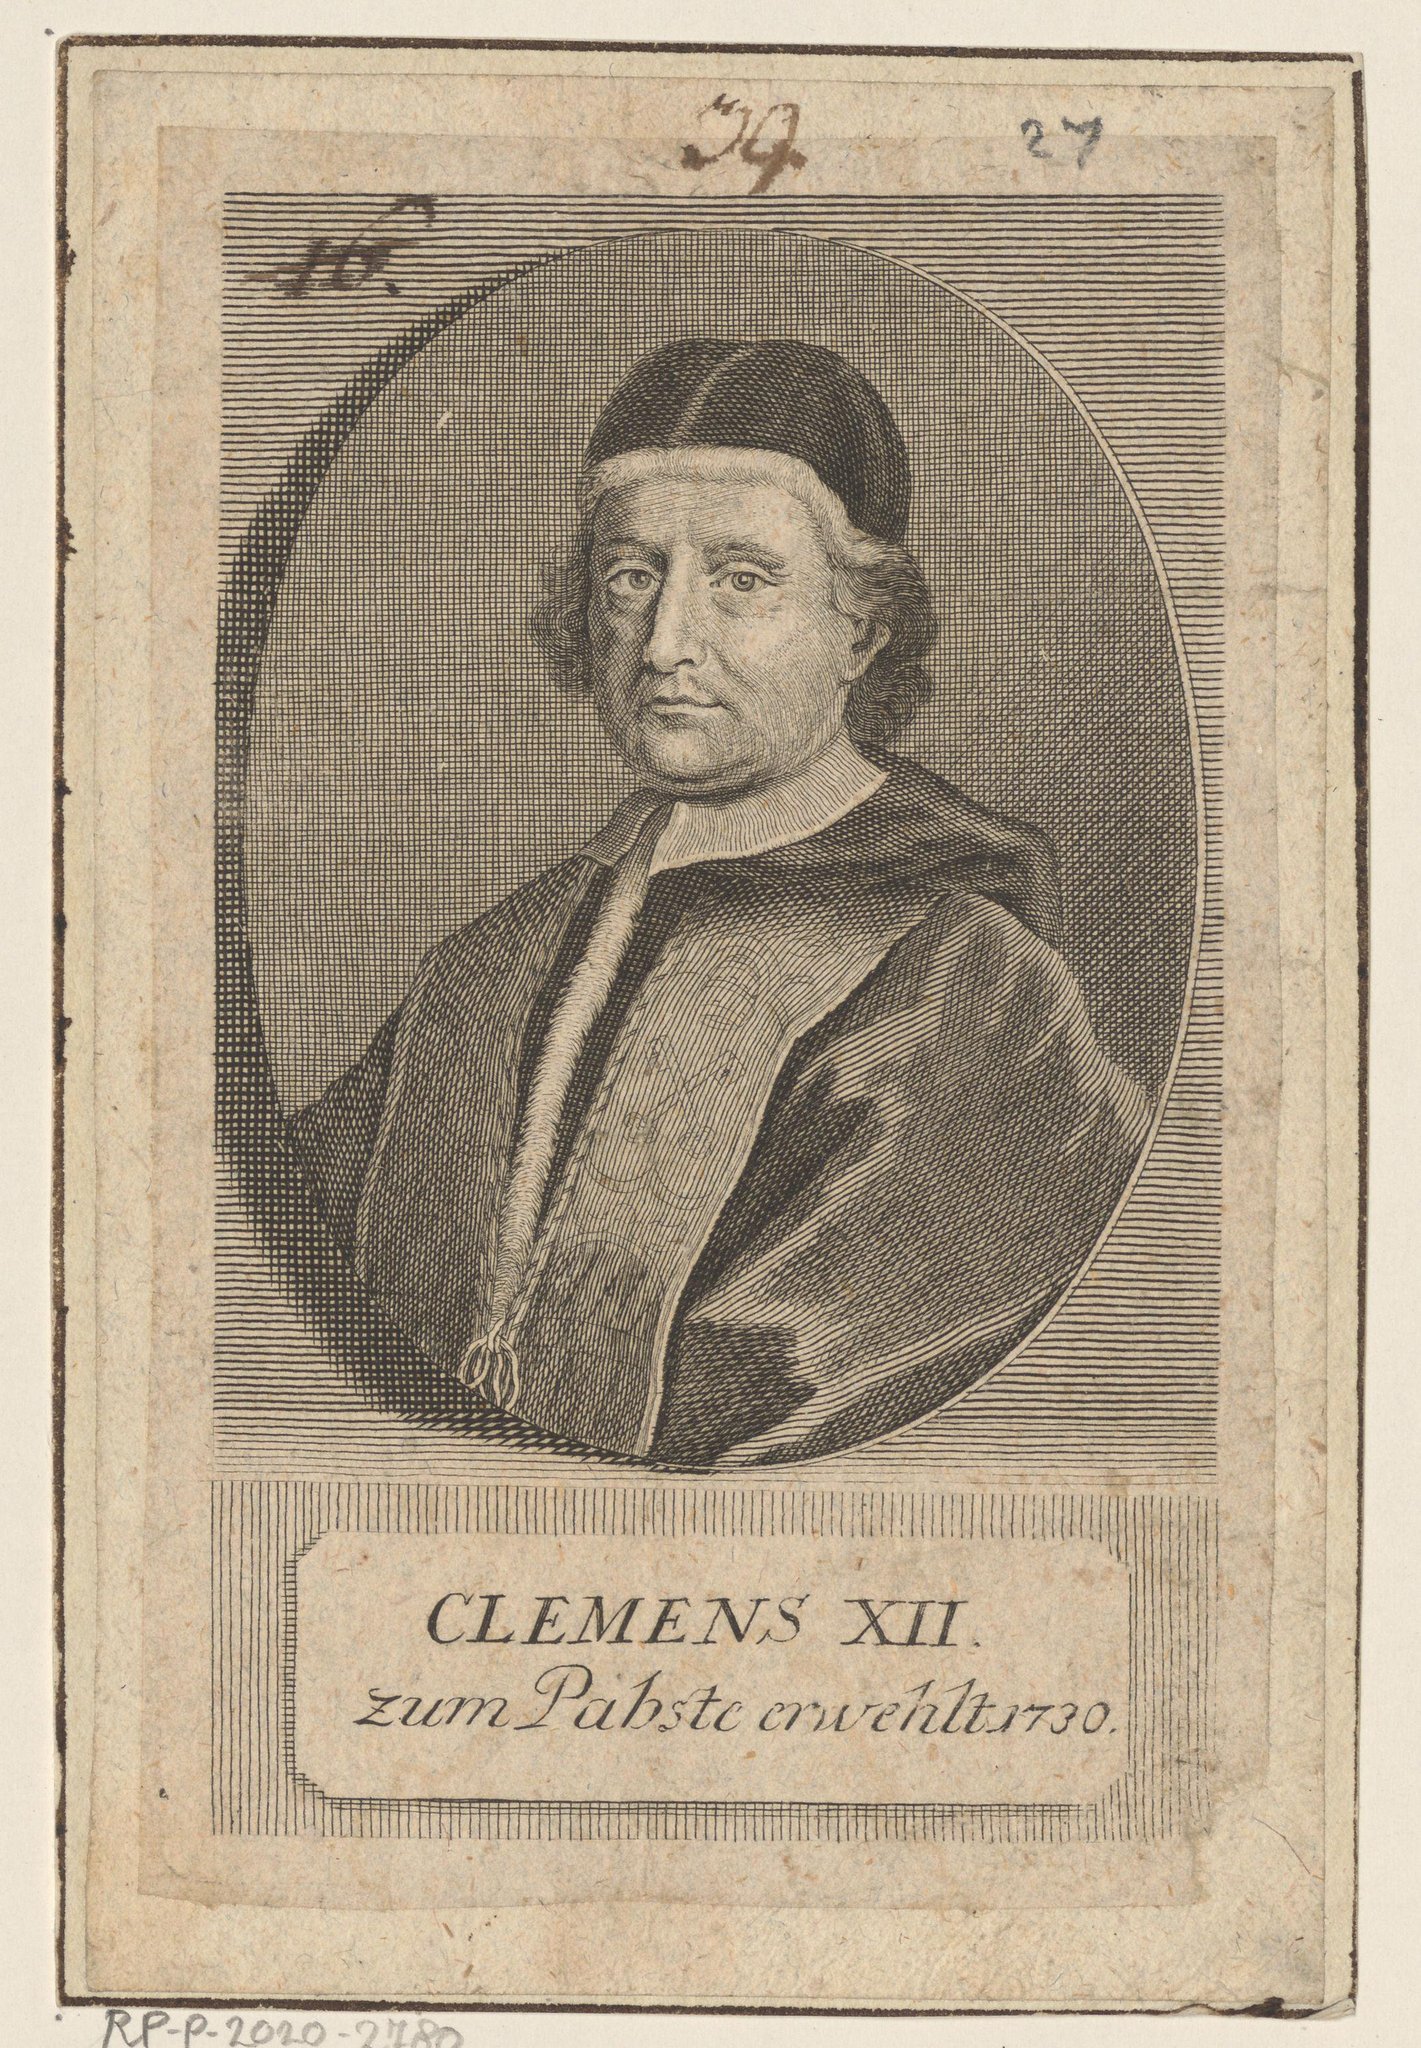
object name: print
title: Portret van paus Clemens XII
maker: Anonymous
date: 1730-1799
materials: paper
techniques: engraving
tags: rome, clemens xii, historical persons, pope